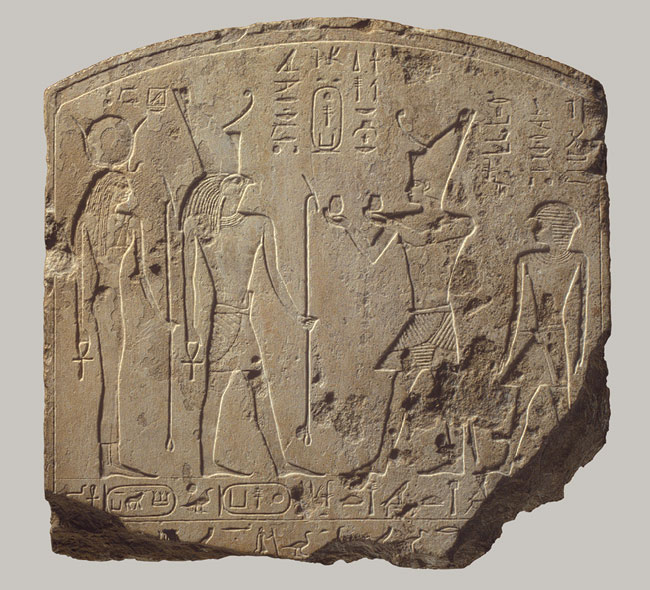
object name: stela, shebitqo, donation, patjenef, horus, hathor, hurbeit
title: Donation Stela of Shebitqo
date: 707-690 BCE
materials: limestone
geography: egypt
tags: hieroglyphs